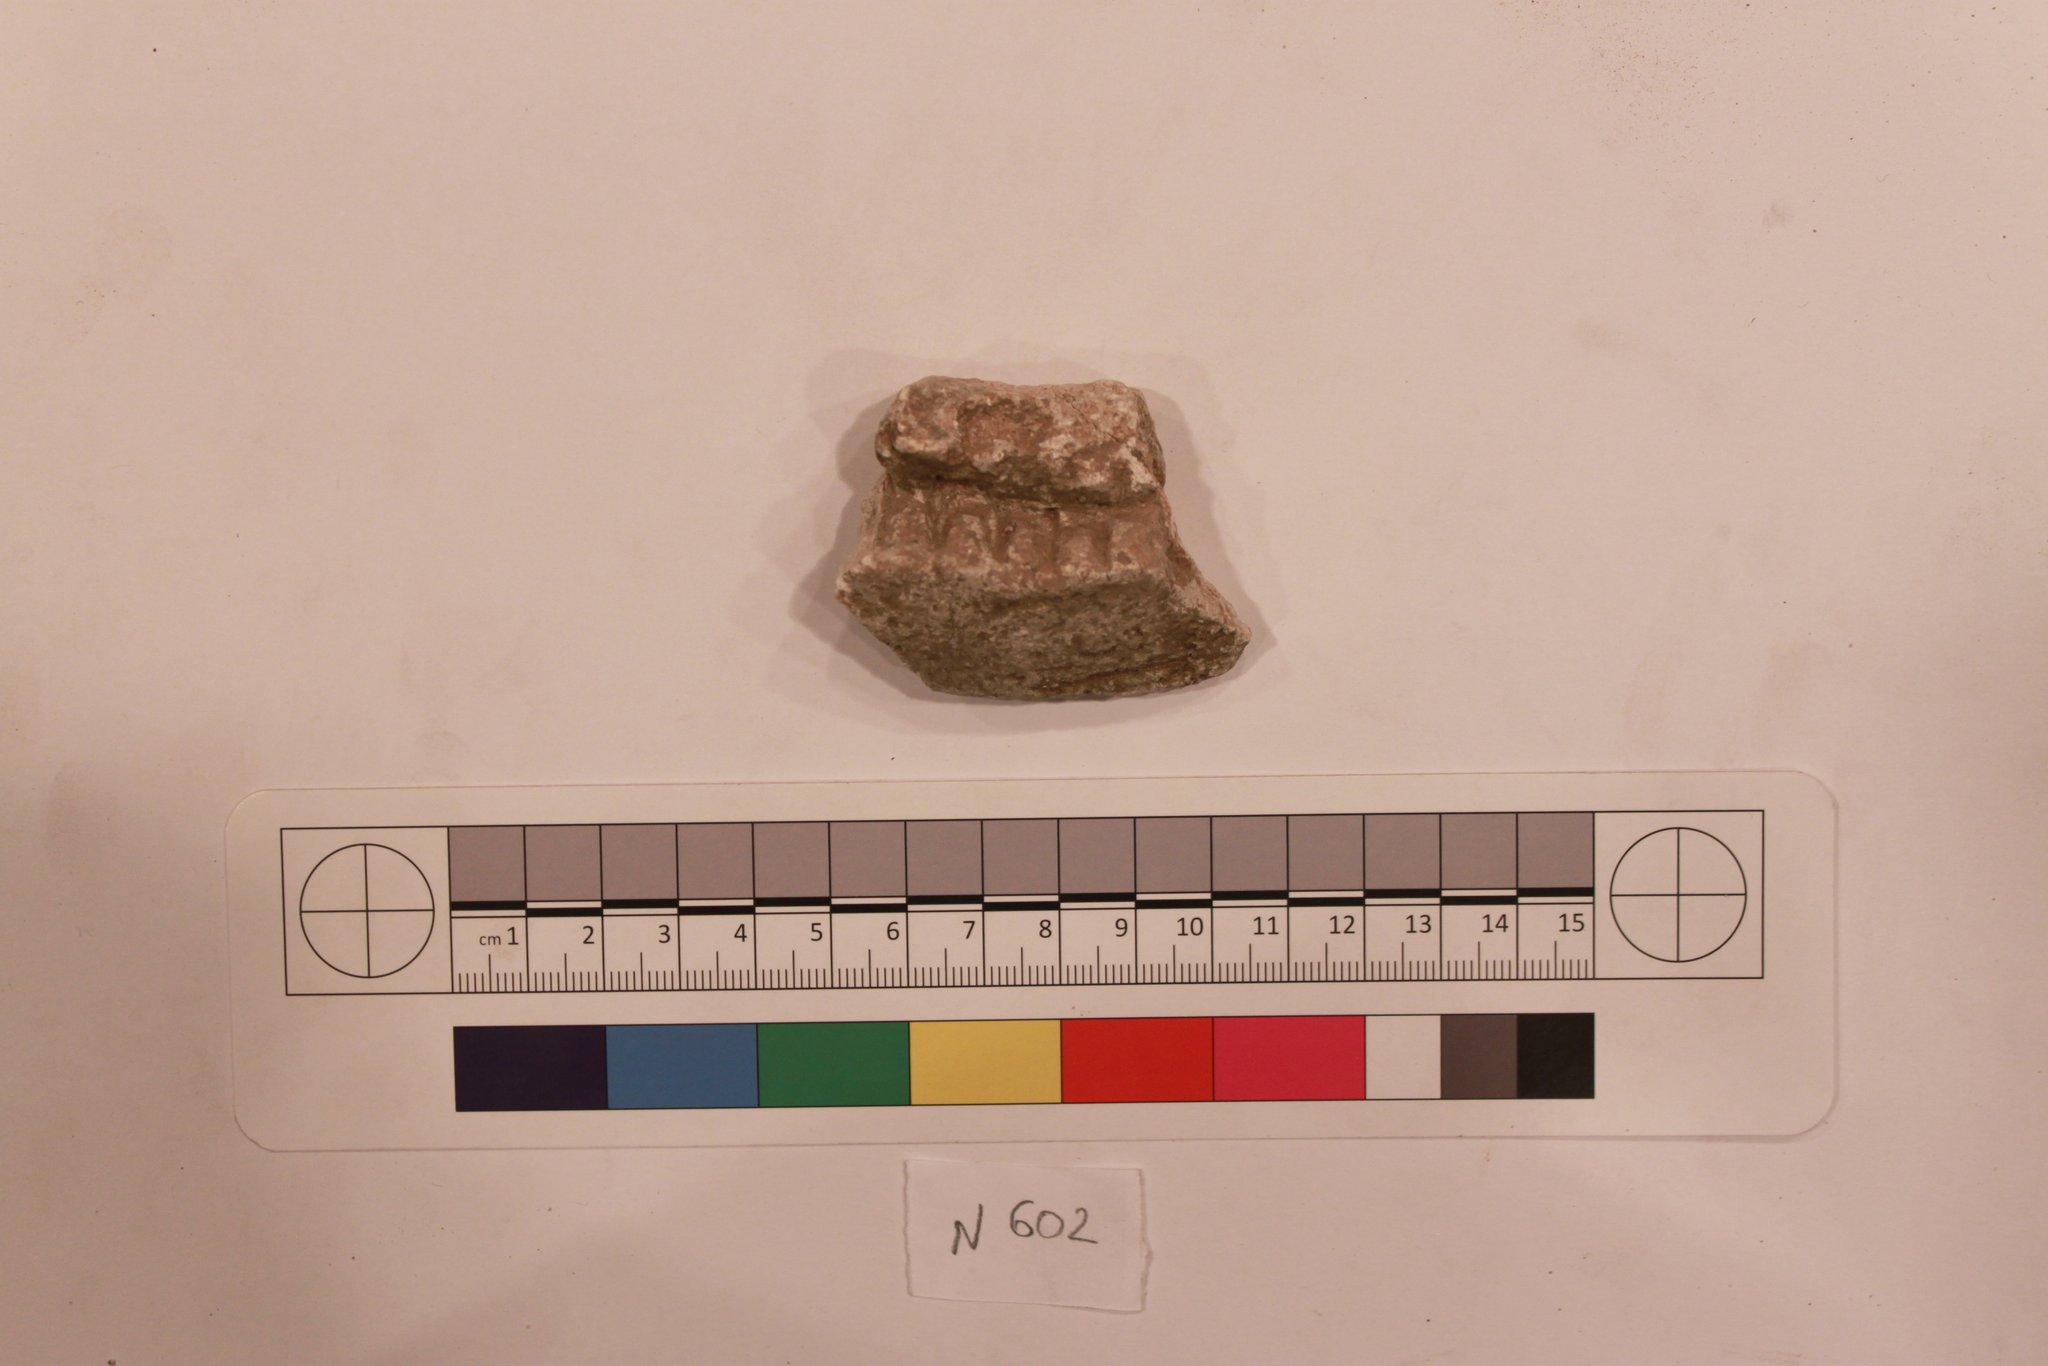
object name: fragment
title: Stucco Fragment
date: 701-1200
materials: plaster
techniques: carving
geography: iran